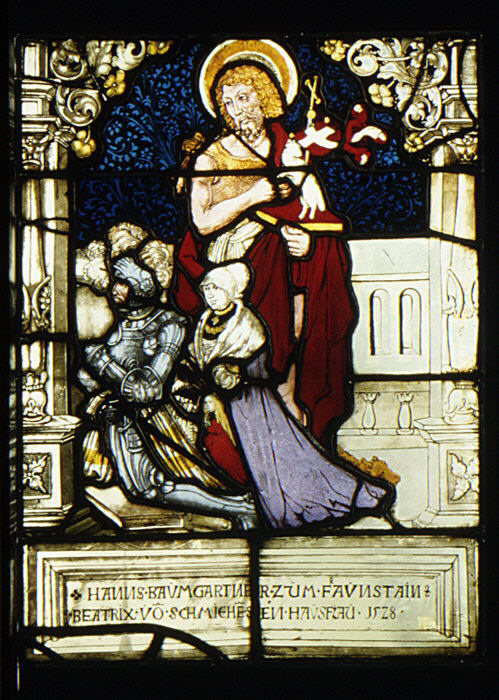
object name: panel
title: St. John the Baptist standing behind donor, Hanns Baumgartner, and his family (one of a pair)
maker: hans wertinger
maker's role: artist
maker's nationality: german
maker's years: 1465-1533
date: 1528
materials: glass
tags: men,women,saint john the baptist